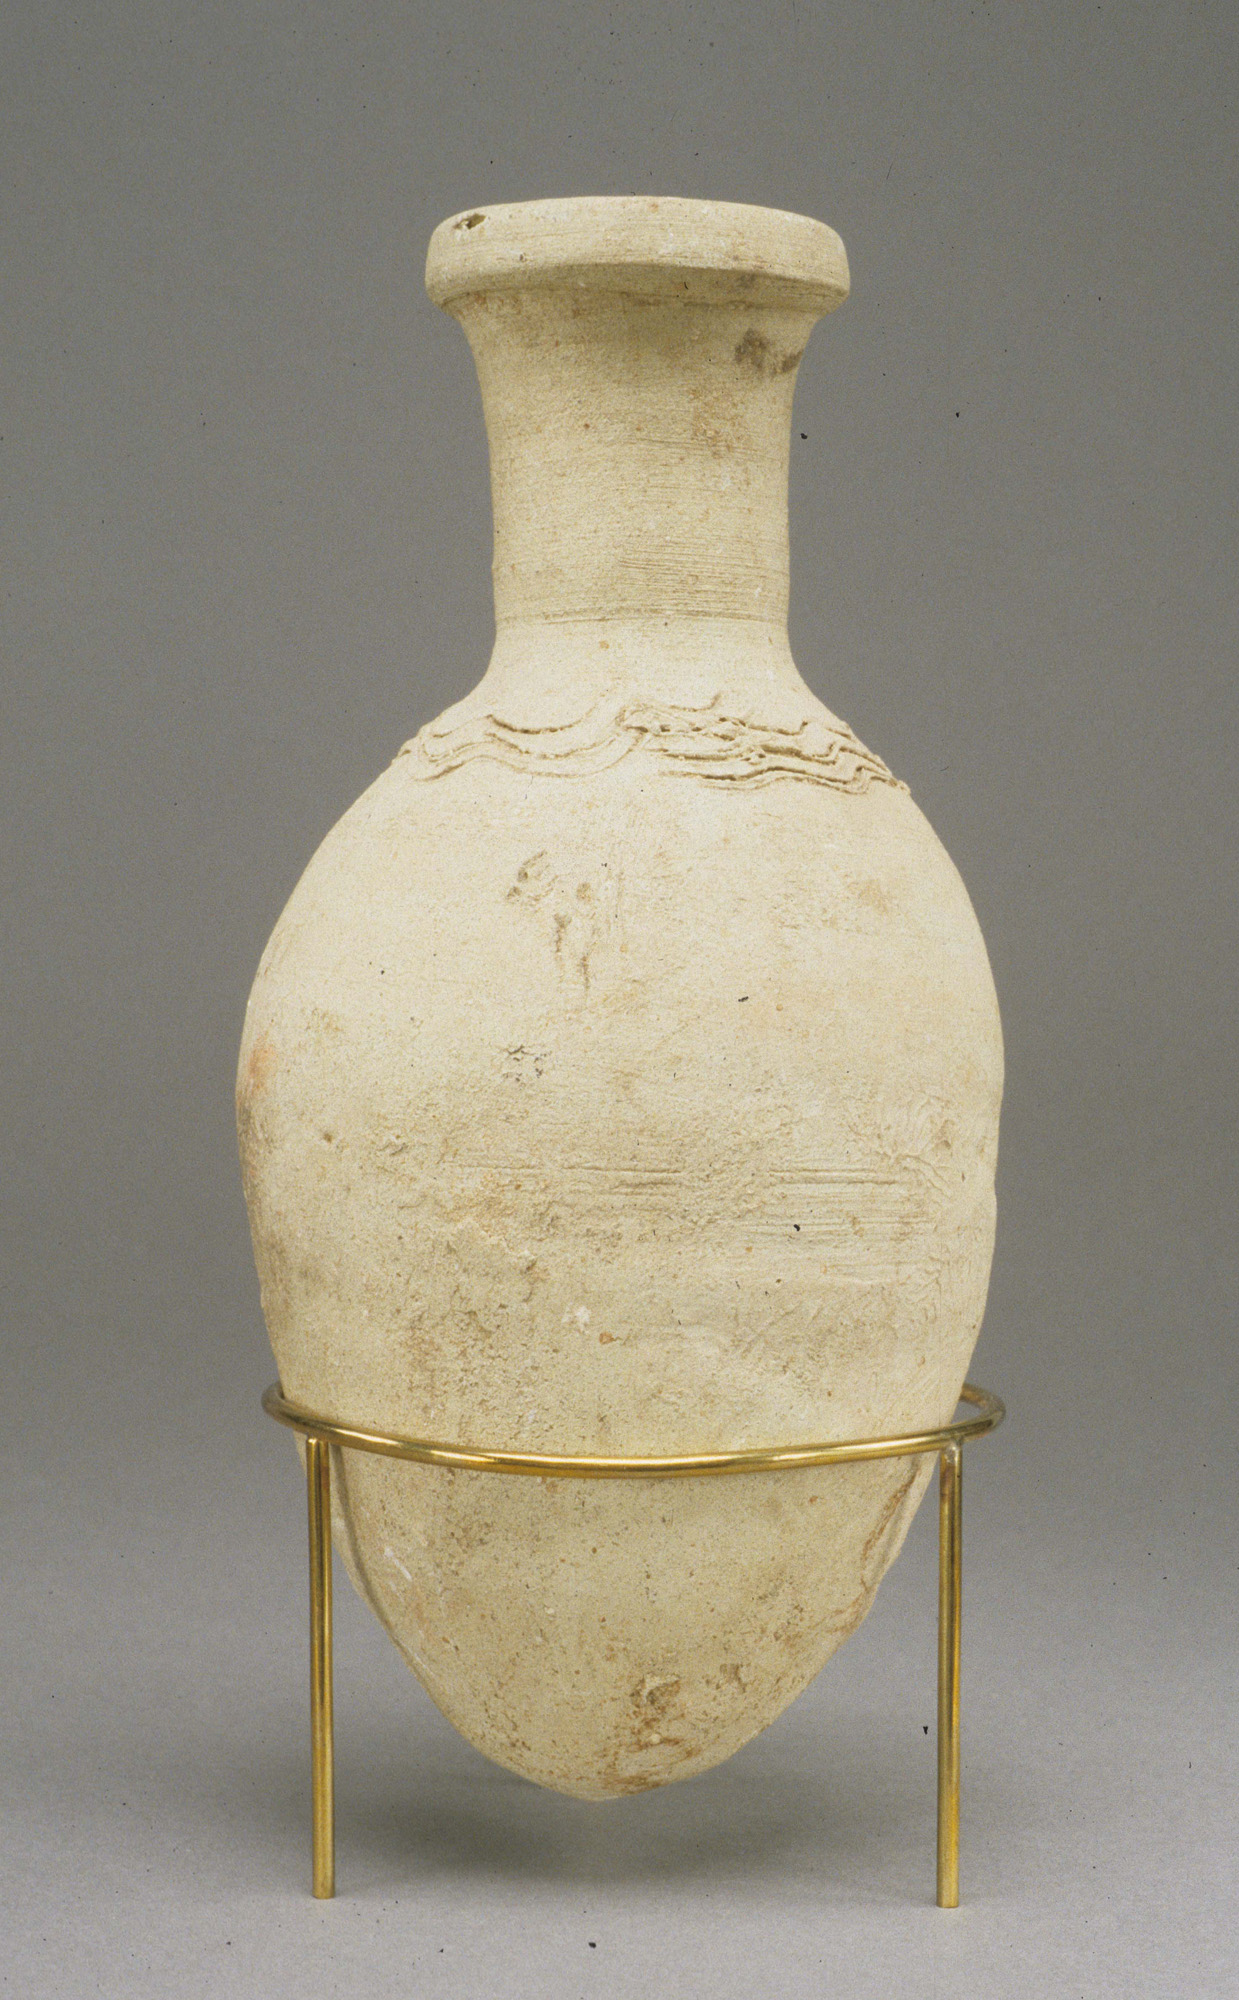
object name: jar, bottle necked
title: Bottle-necked jar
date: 2030-1550 BCE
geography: egypt